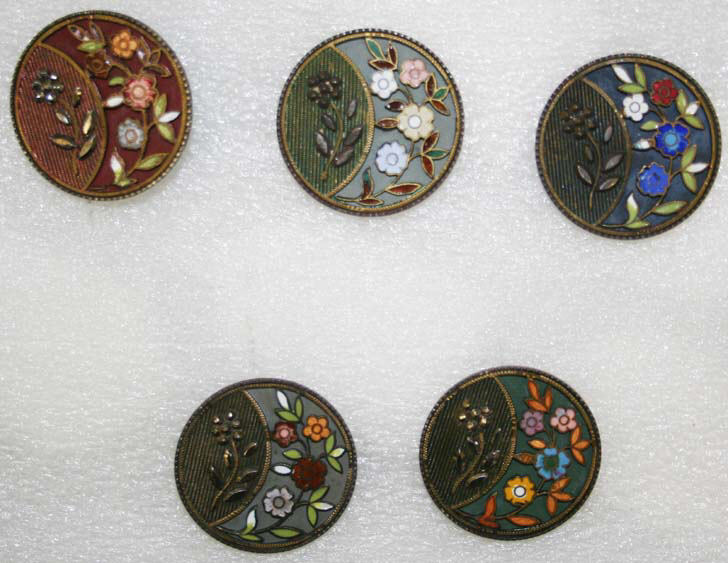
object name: button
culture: british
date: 1880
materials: enamel, metal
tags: flowers